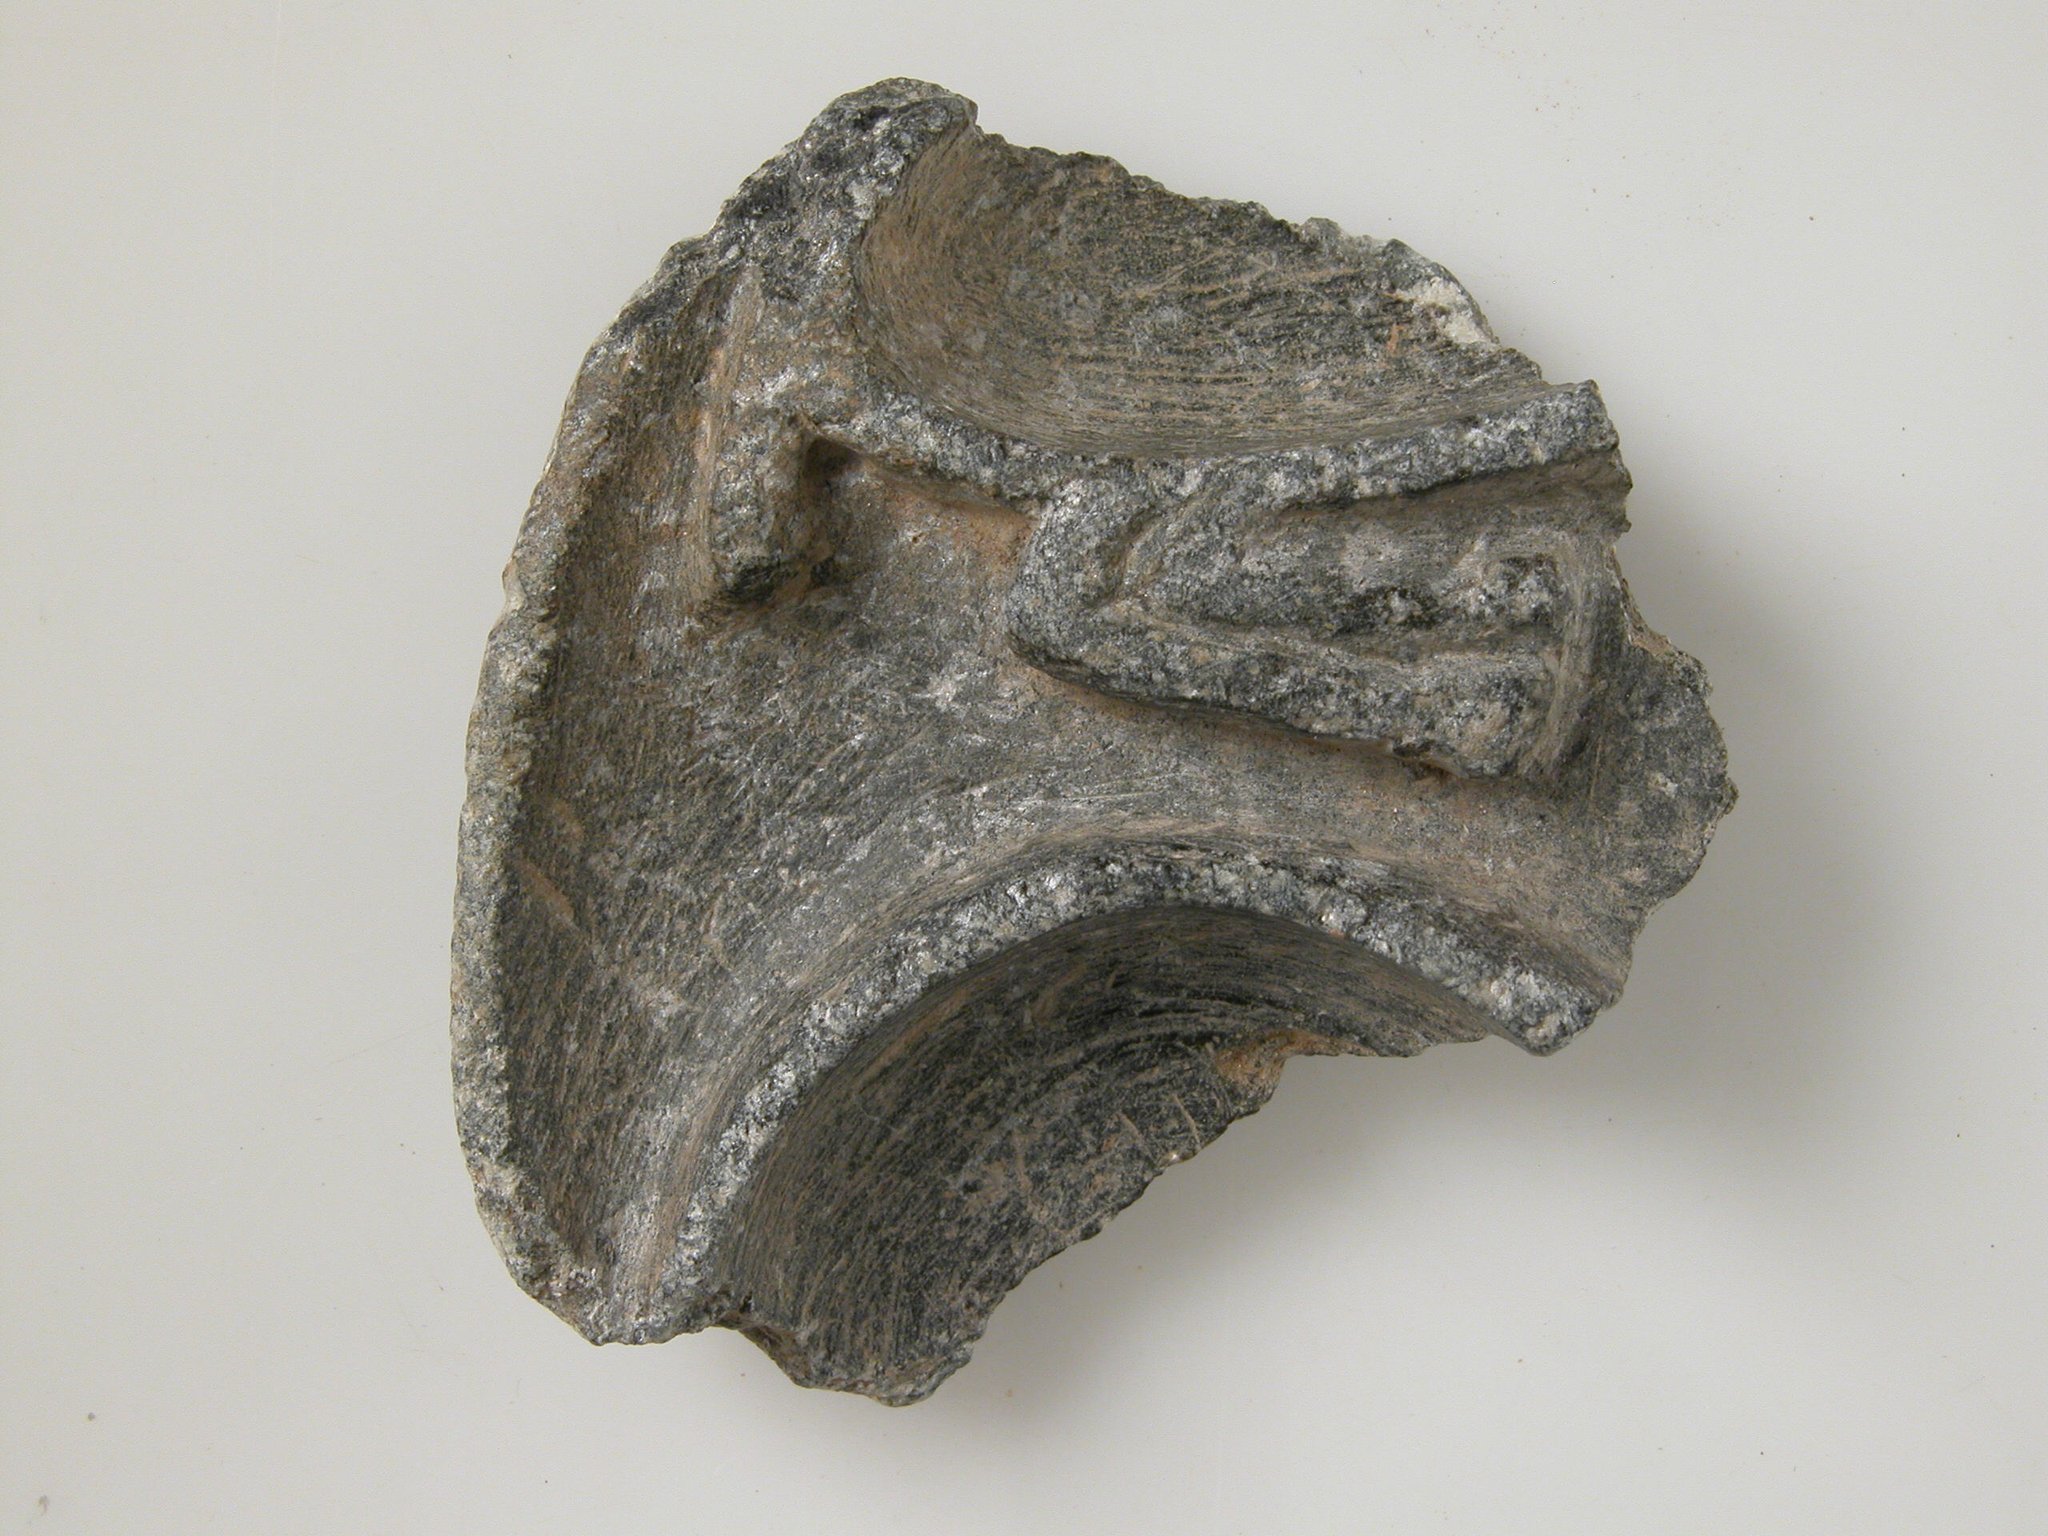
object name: fragment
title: Vessel (?) Fragment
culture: coptic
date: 301-700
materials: stone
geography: egypt